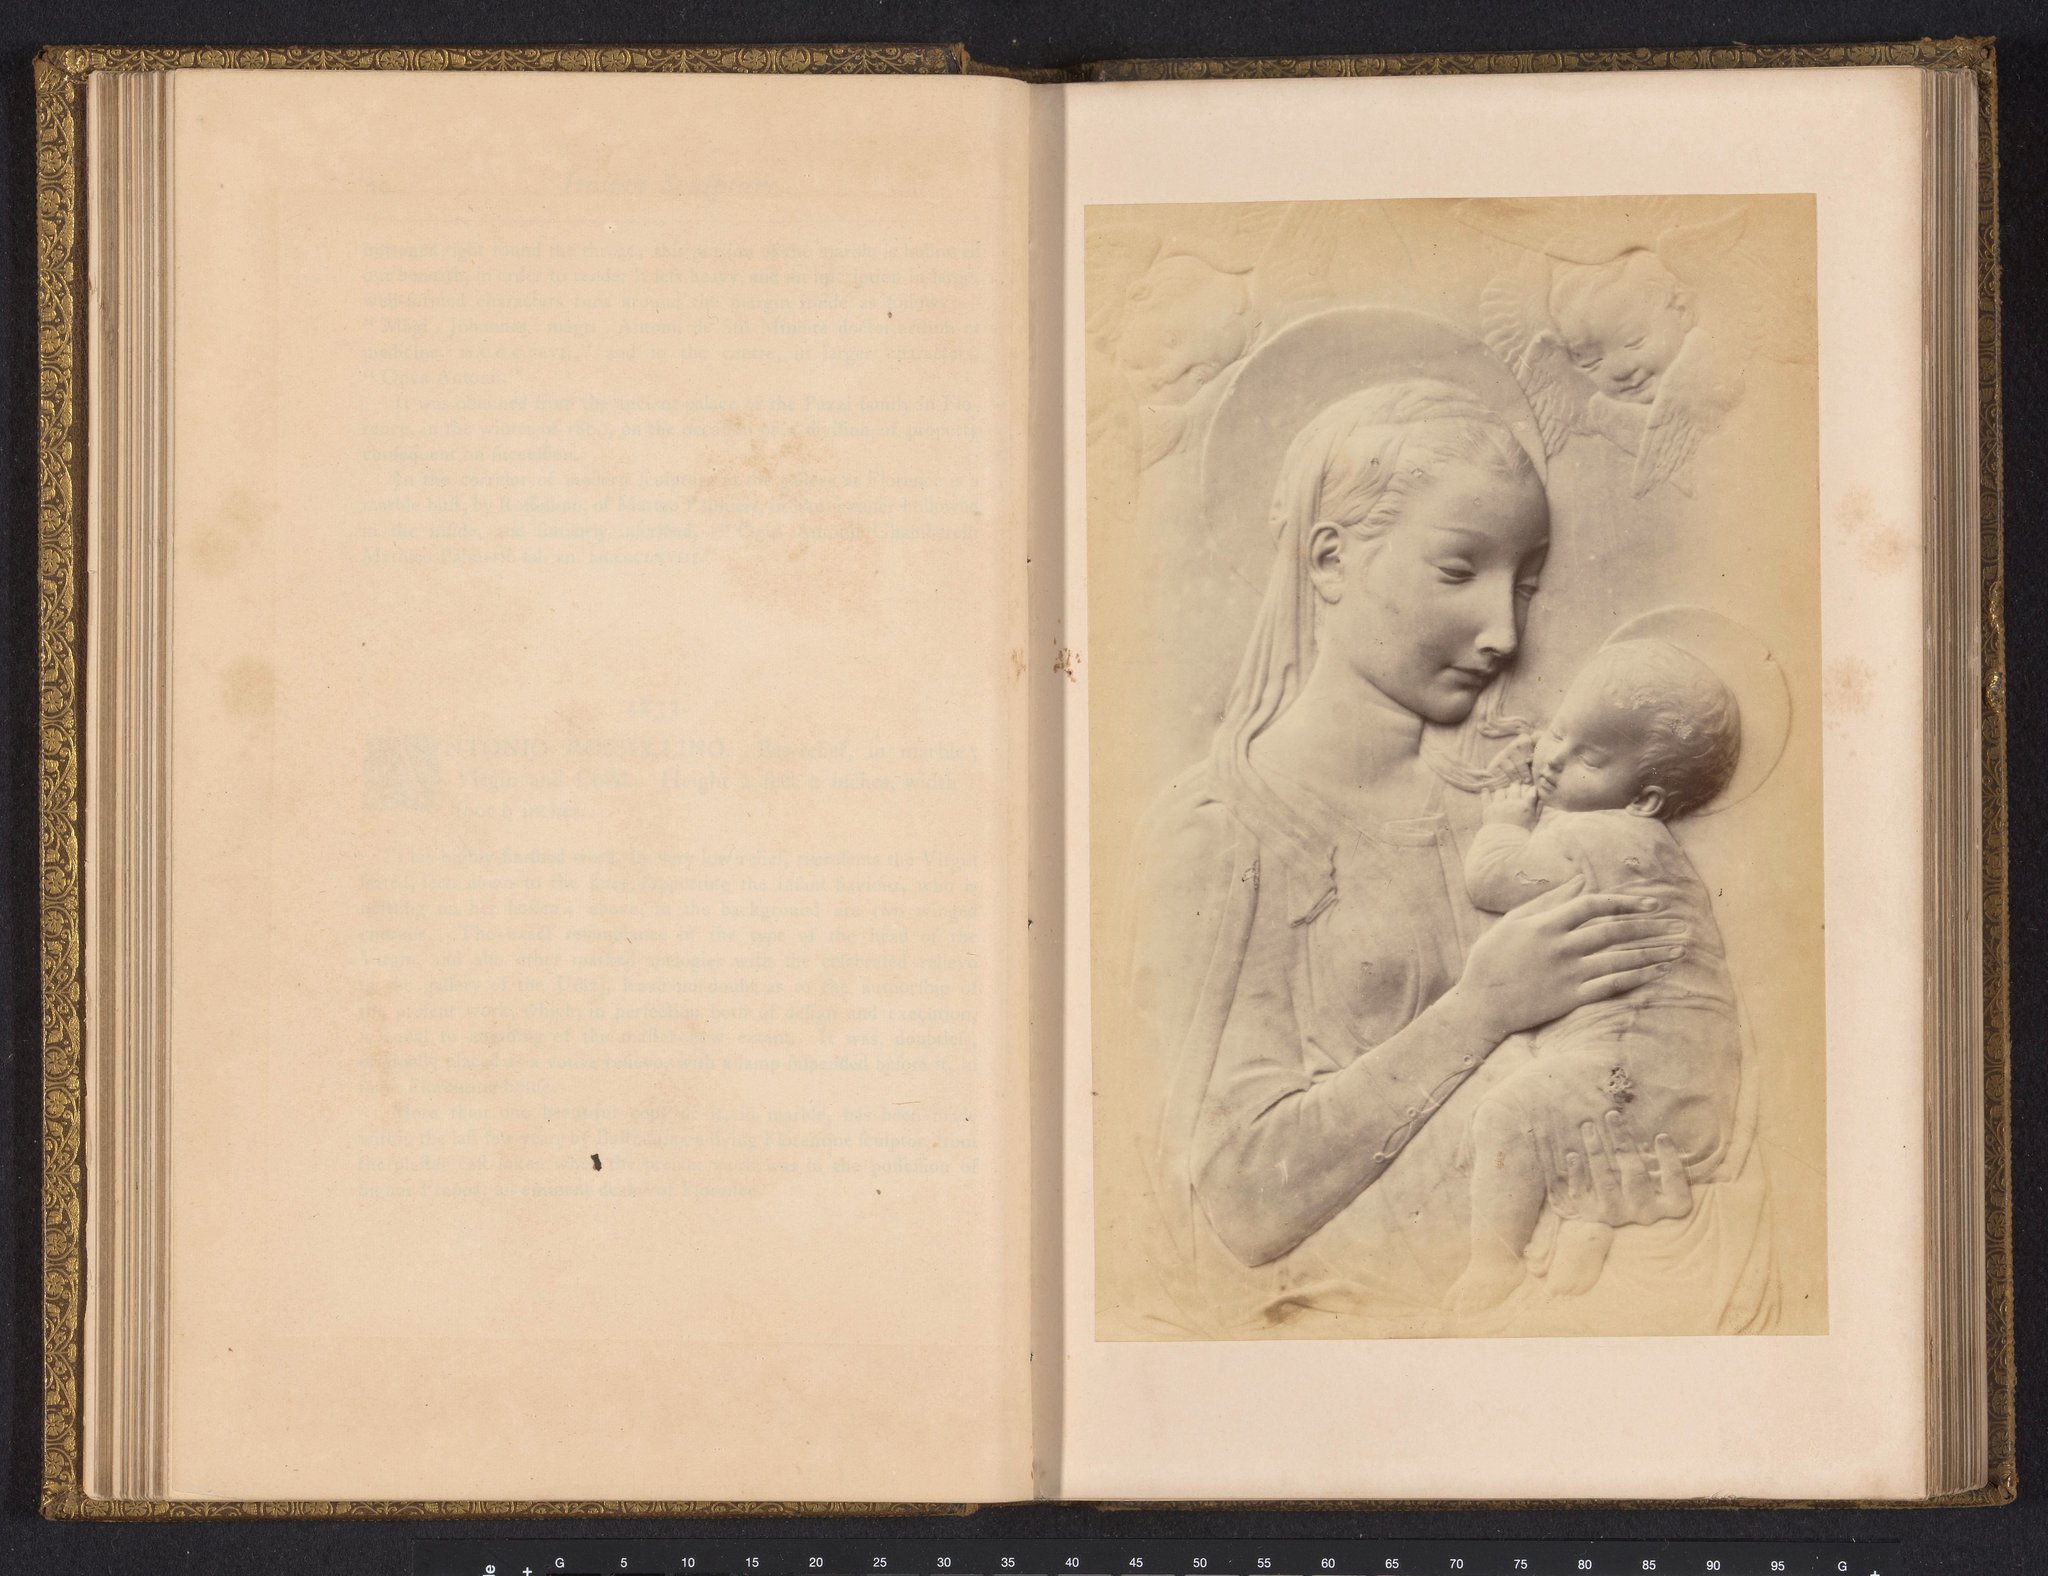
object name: page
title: Reliëf met Maria met Kind door Antonio Rossellino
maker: Anonymous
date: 1852-1862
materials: photographic support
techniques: albumen print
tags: madonna: i.e. mary with the christ-child, sculpture (+ relief ~ sculpture)